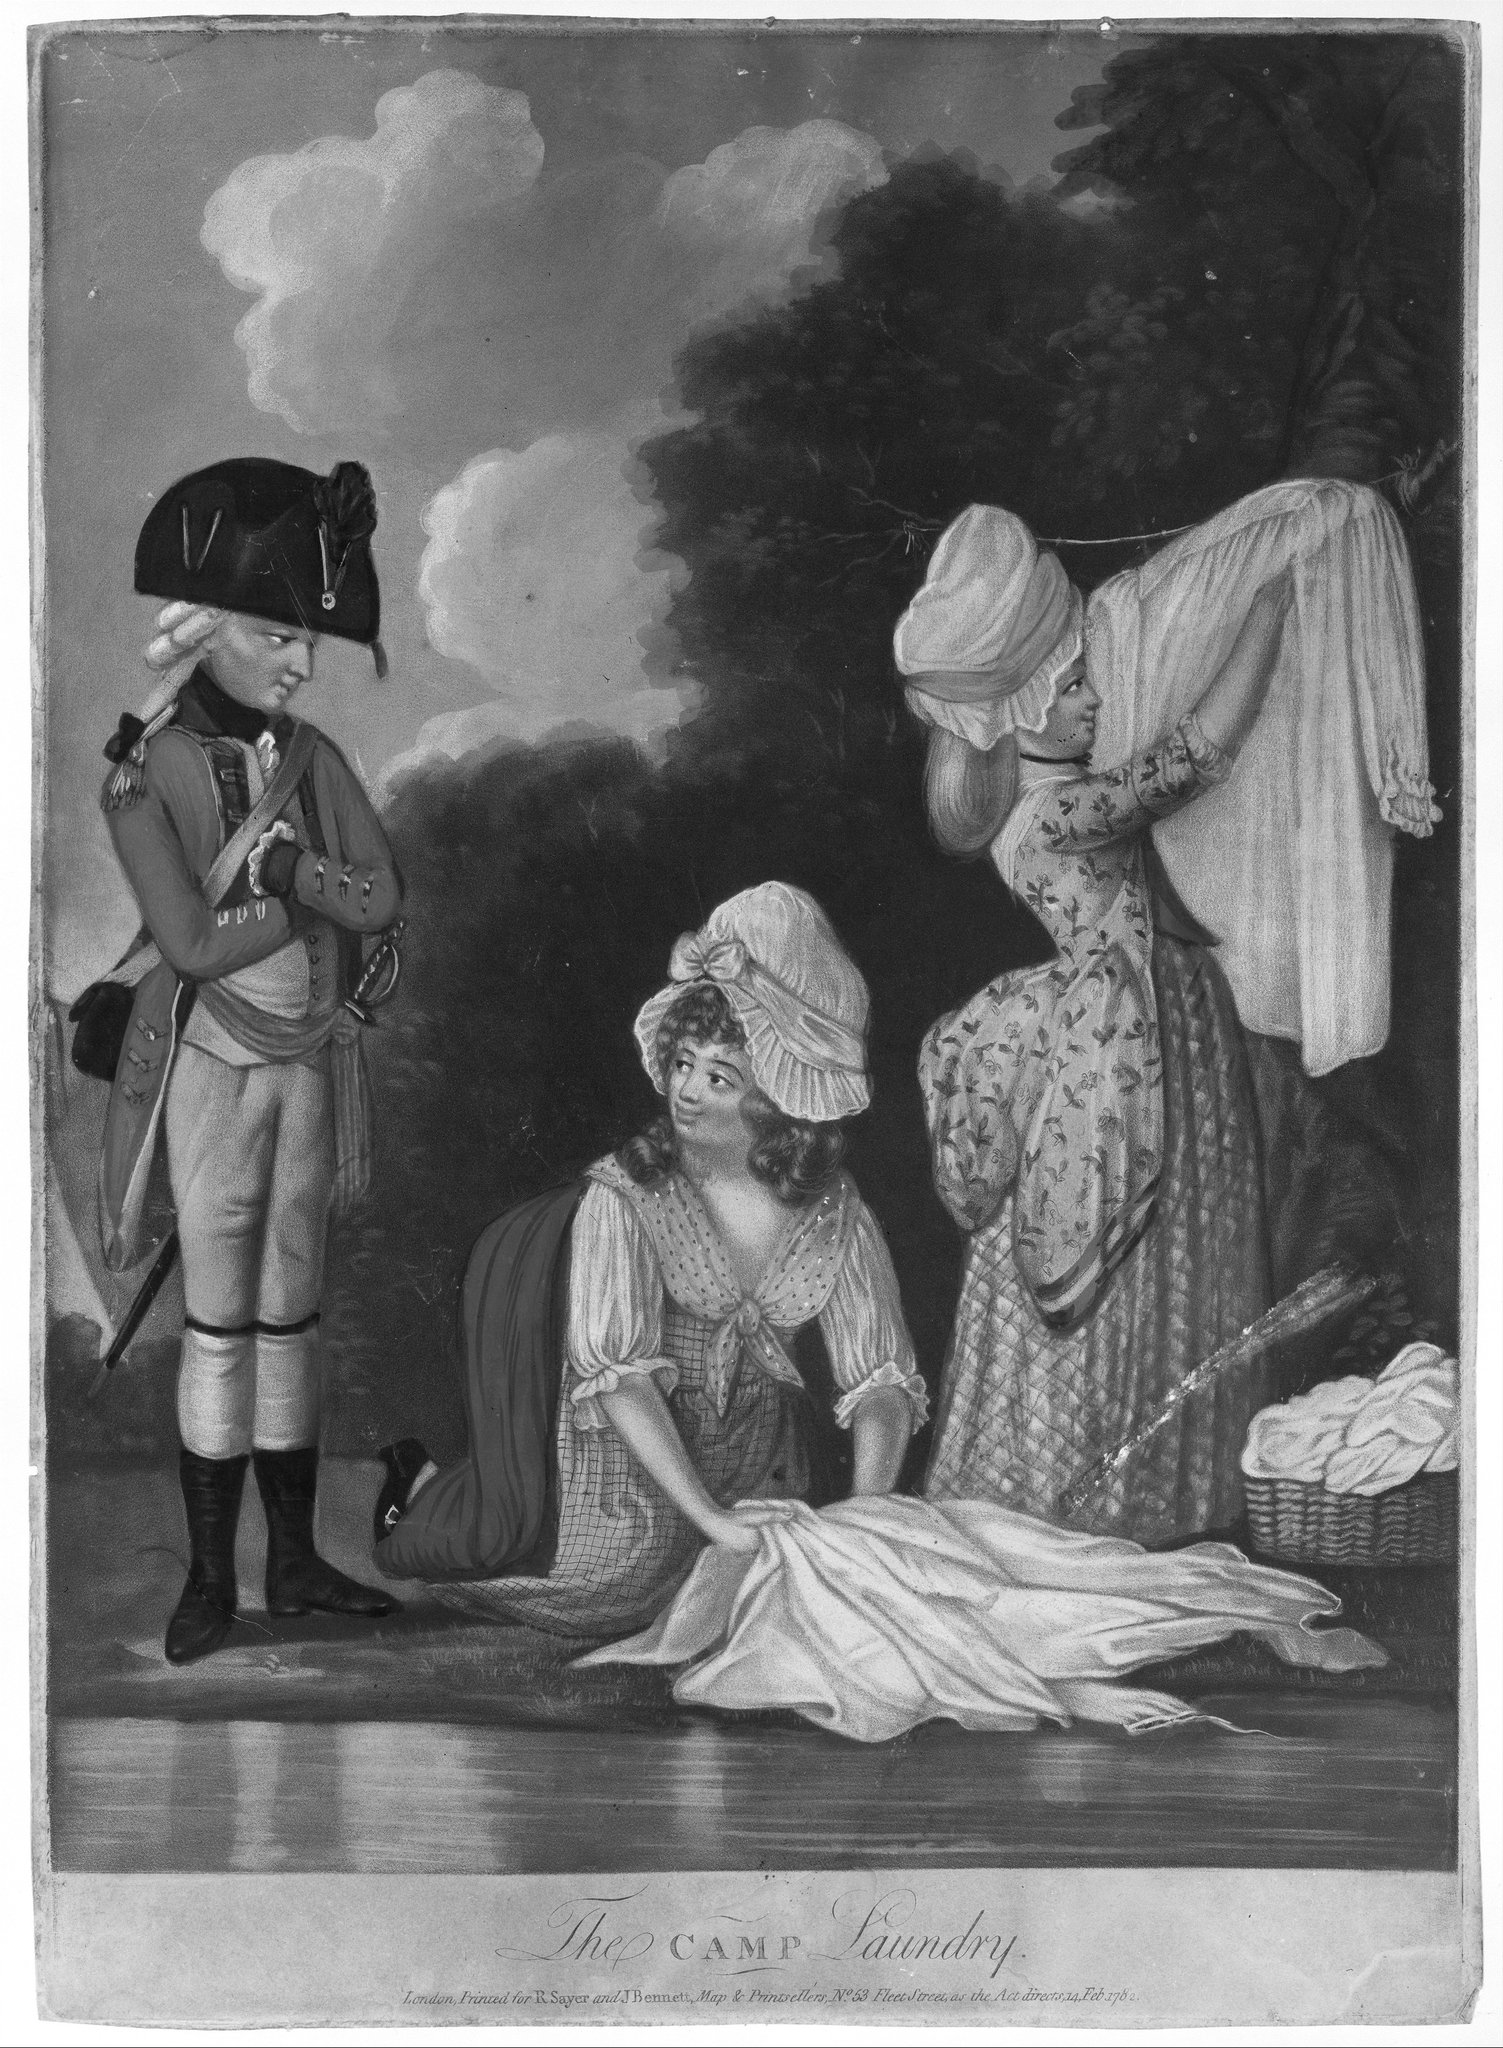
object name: print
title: The Camp Laundry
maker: anonymous, british, 18th century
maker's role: artist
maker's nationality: british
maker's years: 1700-1800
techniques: hand coloring, mezzotint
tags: soldiers,men,women,washing